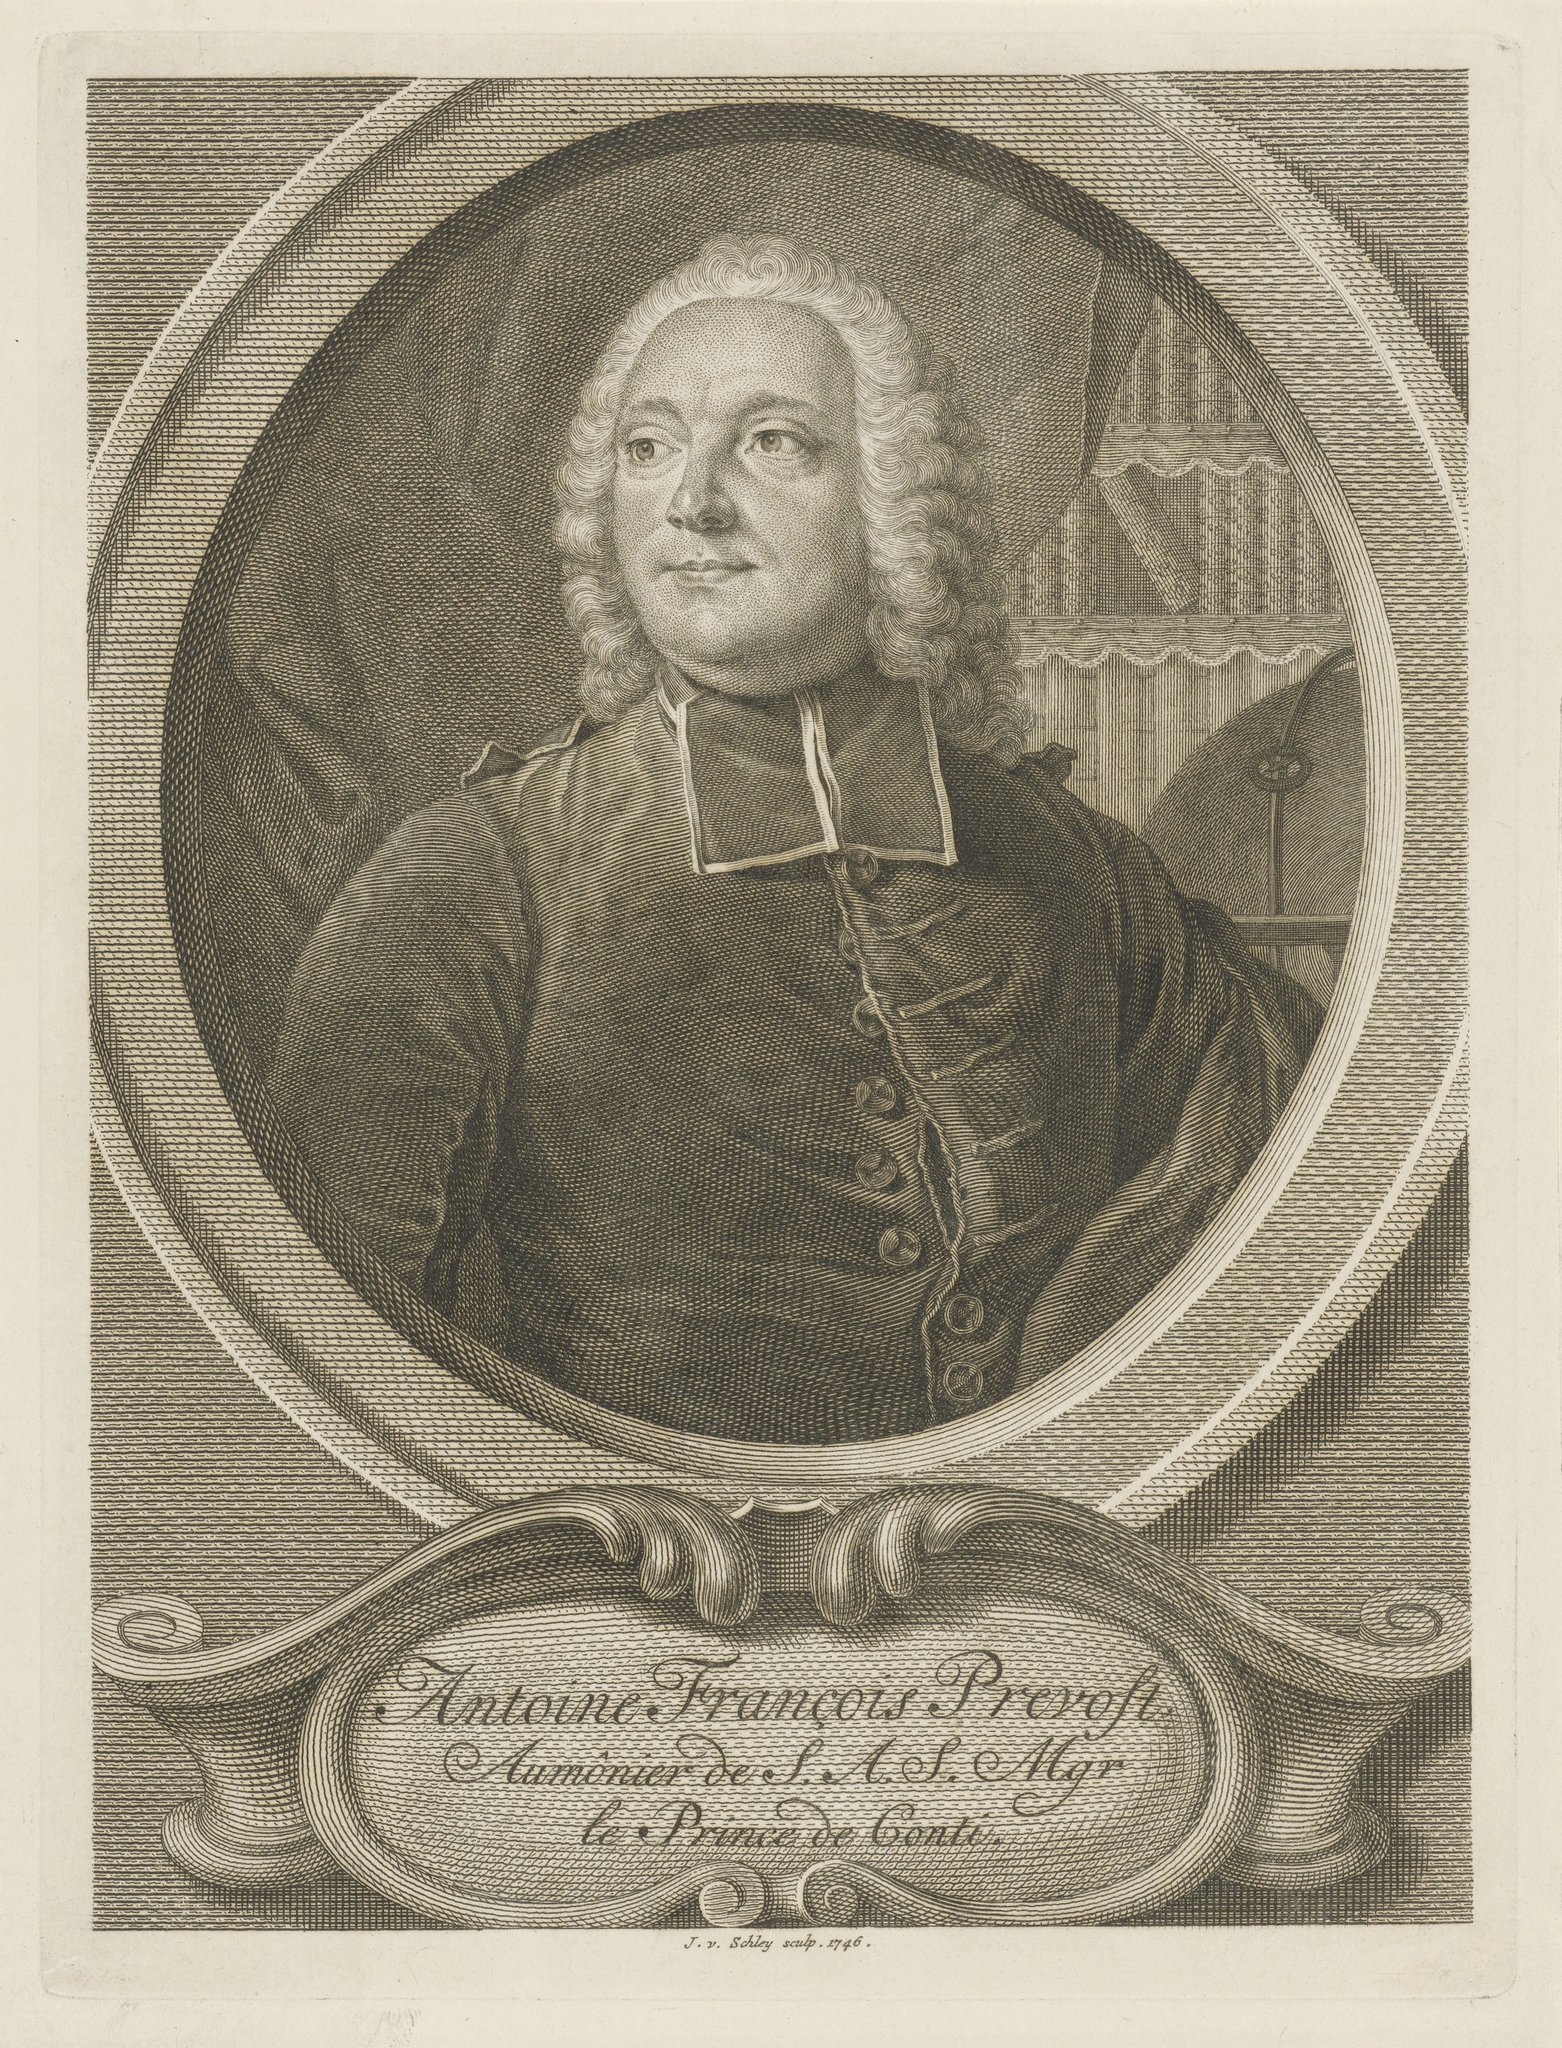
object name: print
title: Portret van Antoine François Prevost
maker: jacob van der schley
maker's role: draughtsman, print maker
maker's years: 1715-1779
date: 1746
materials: paper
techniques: engraving, etching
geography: amsterdam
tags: study; 'studiolo'; library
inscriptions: collector's mark: Lugt 2228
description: Portret van de Franse auteur Antoine François Prevost, tevens bekend als Abbé Prévost. Hij is gekleed in toga met bef. Op de achtergrond een boekenkast. In de cartouche zijn naam en titels.